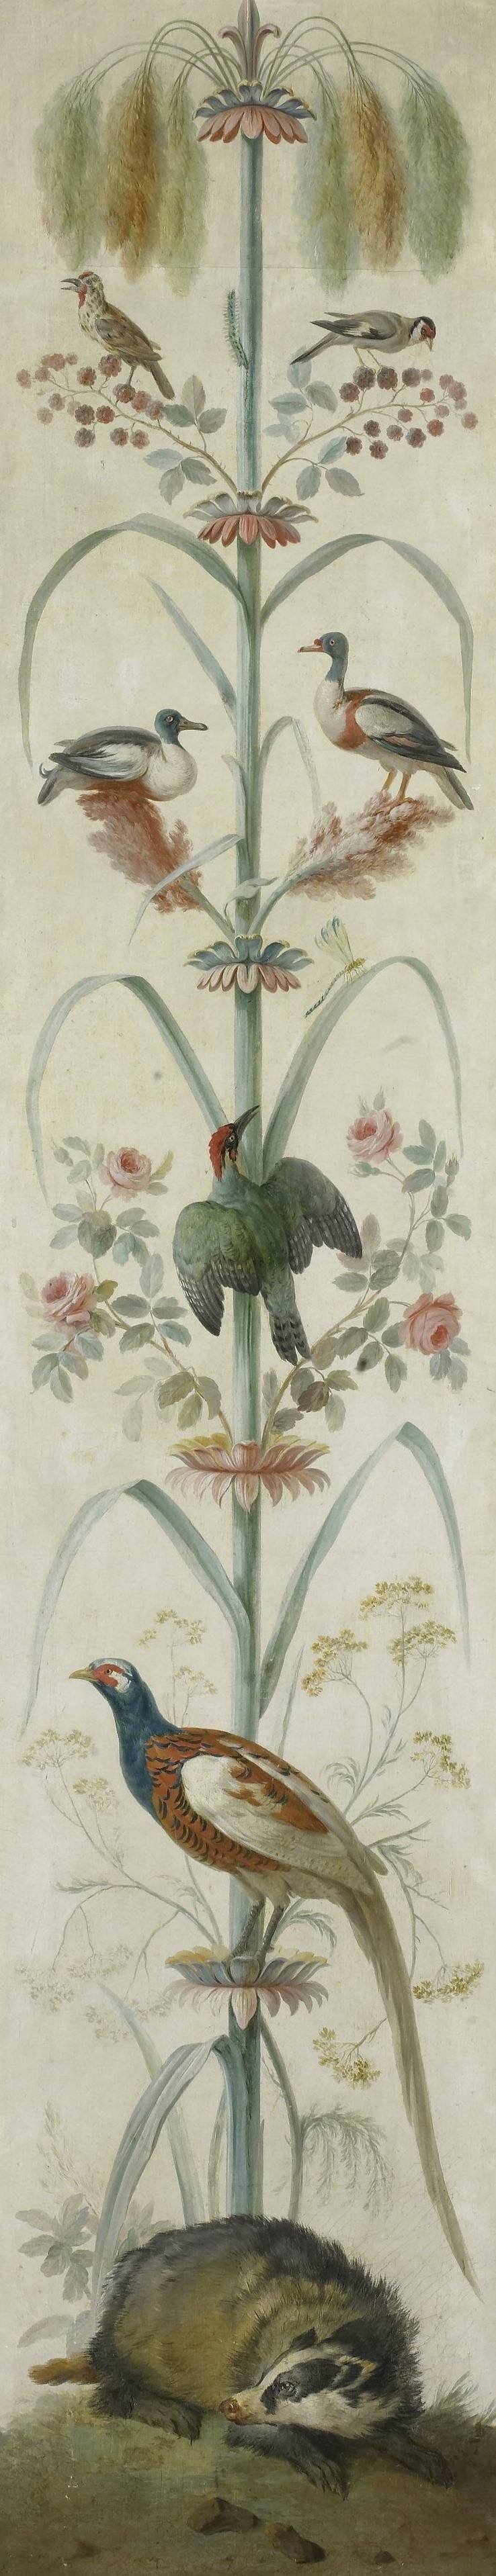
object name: painting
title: Decorative Depiction with Plants and Animals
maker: Anonymous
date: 1760-1799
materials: canvas, oil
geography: france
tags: birds, walker and runner birds: pheasant, beasts of prey, predatory animals: badger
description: French school, c. 1775. Four decorative paintings with plants and animals.